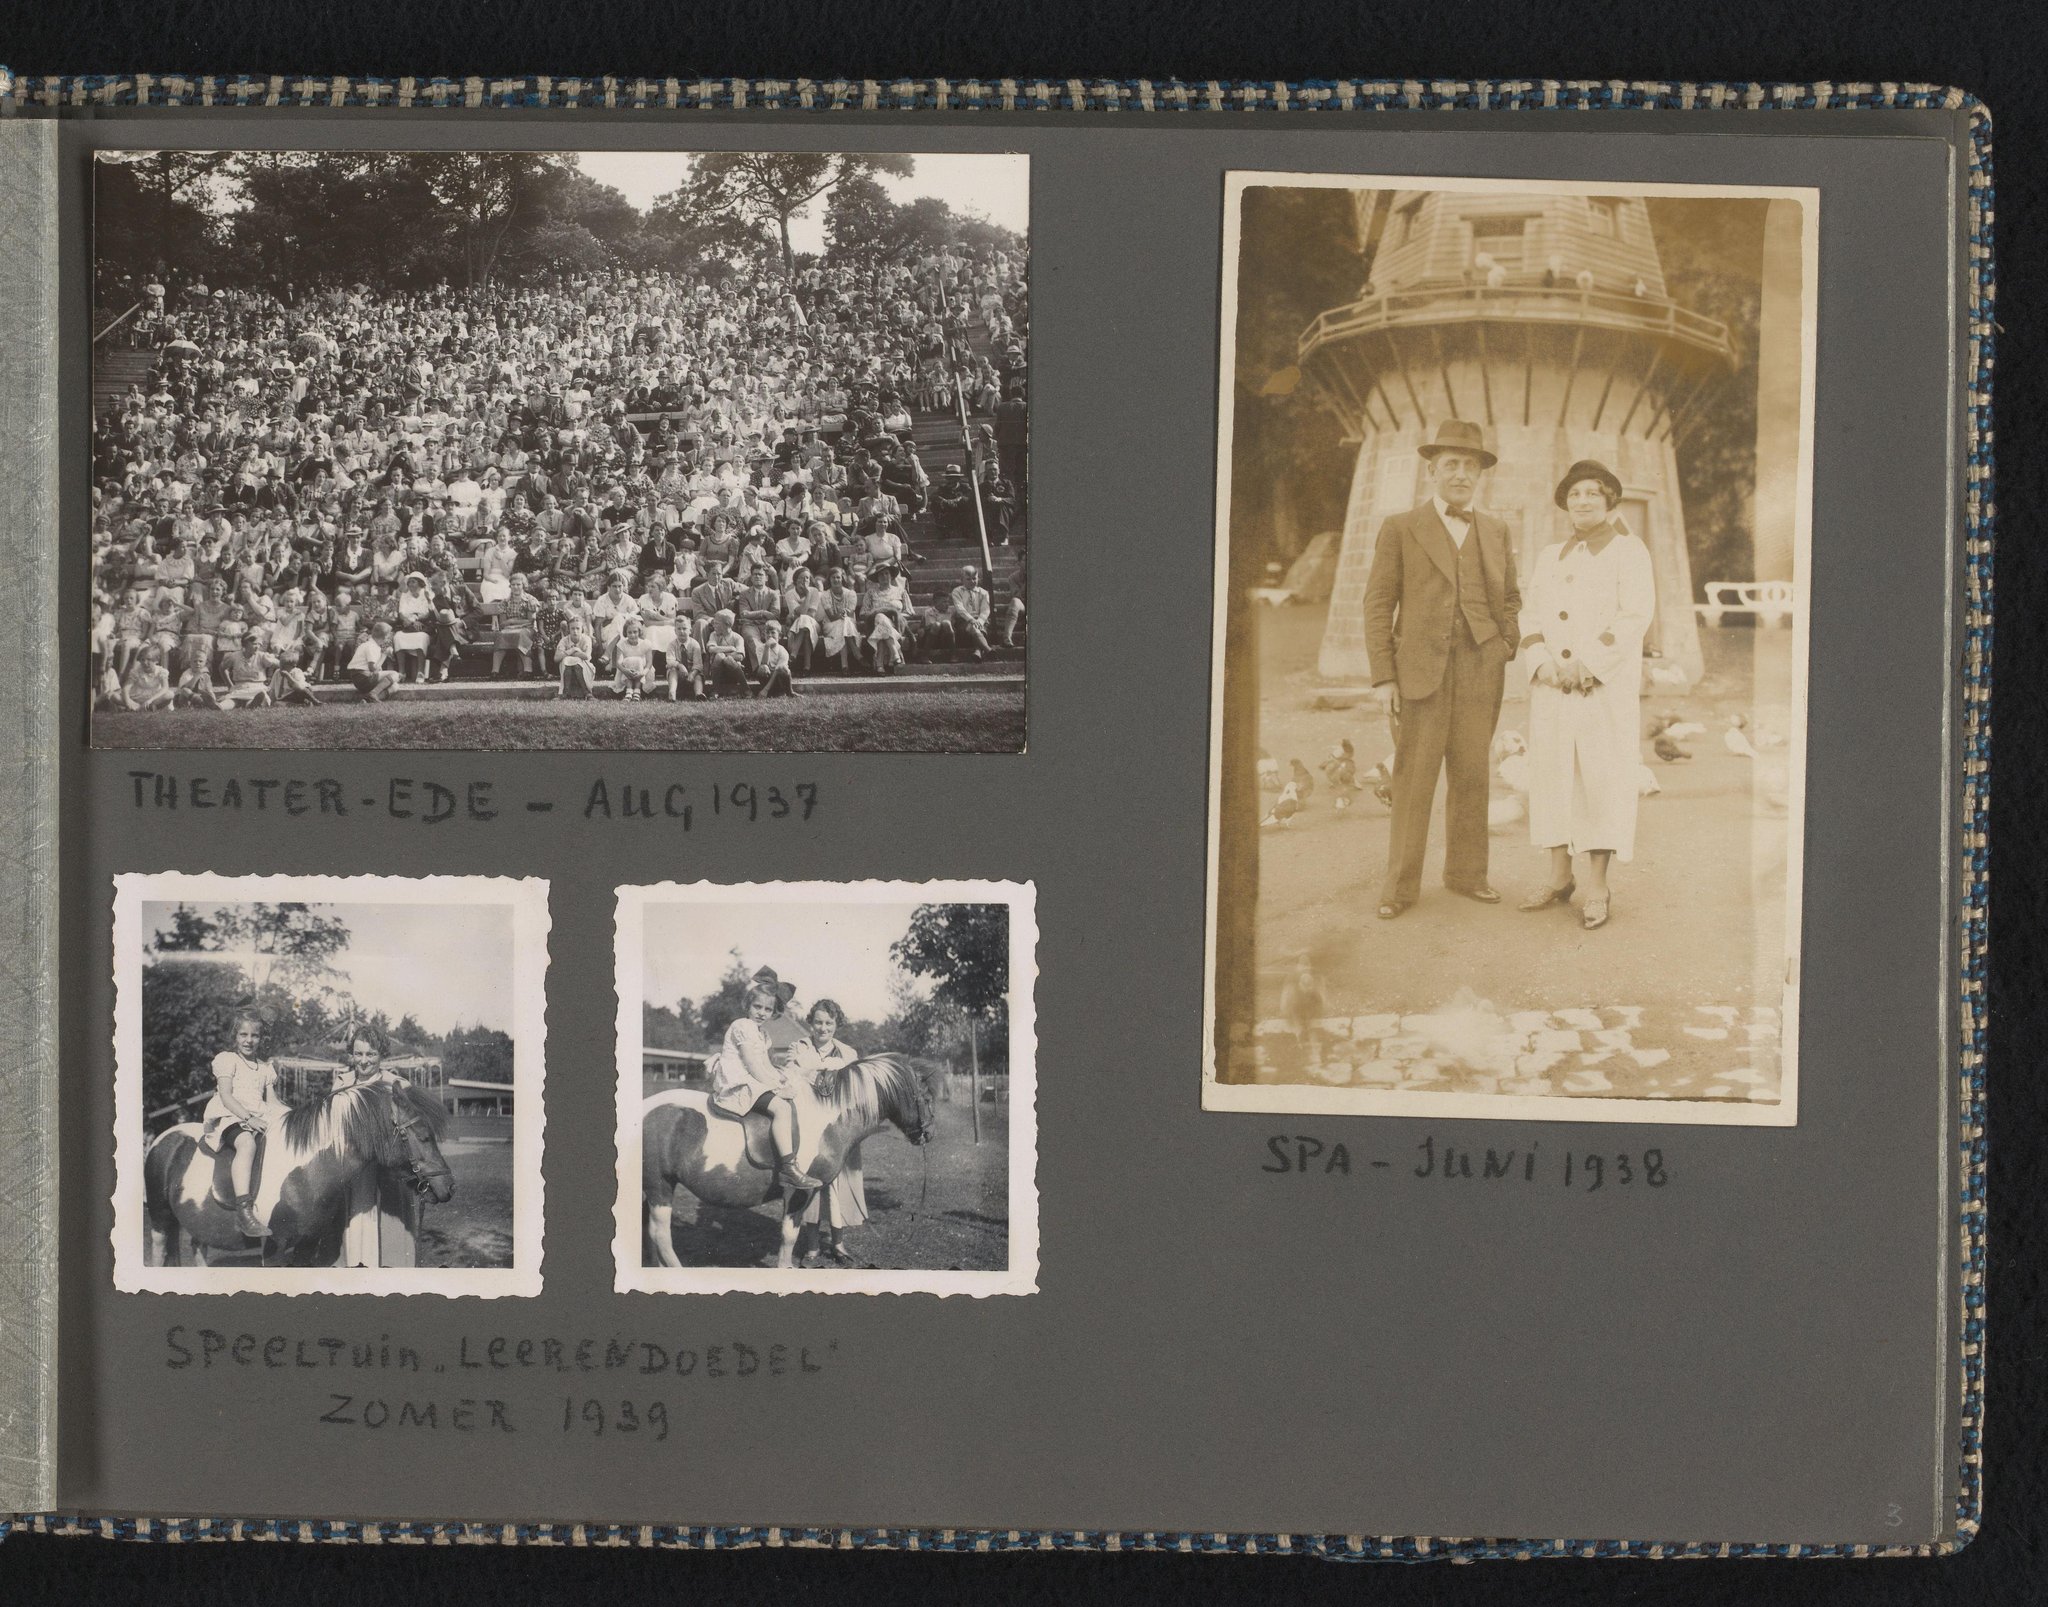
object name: photograph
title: Diverse uitjes 1937-1939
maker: Anonymous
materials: paper, photographic support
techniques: gelatin silver print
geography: spa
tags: riding a horse, ass, or mule; rider, horseman, the family travelling, on holiday, outing, pleasure trip, theatre (building) - aa - open-air performances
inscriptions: inscription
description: Abumblad met vier foto's van publiek in openluchttheater in Ede in augustus 1937, het echtpaar in Spa in juni 1938 en moeder met dochter met pony in Speeltuin Leerendoedel in de zomer van 1939. Onderdeel van het fotoalbum van het gezin van een Nederlandse officier in krijgsgevangenschap in Kamp Stanislau.